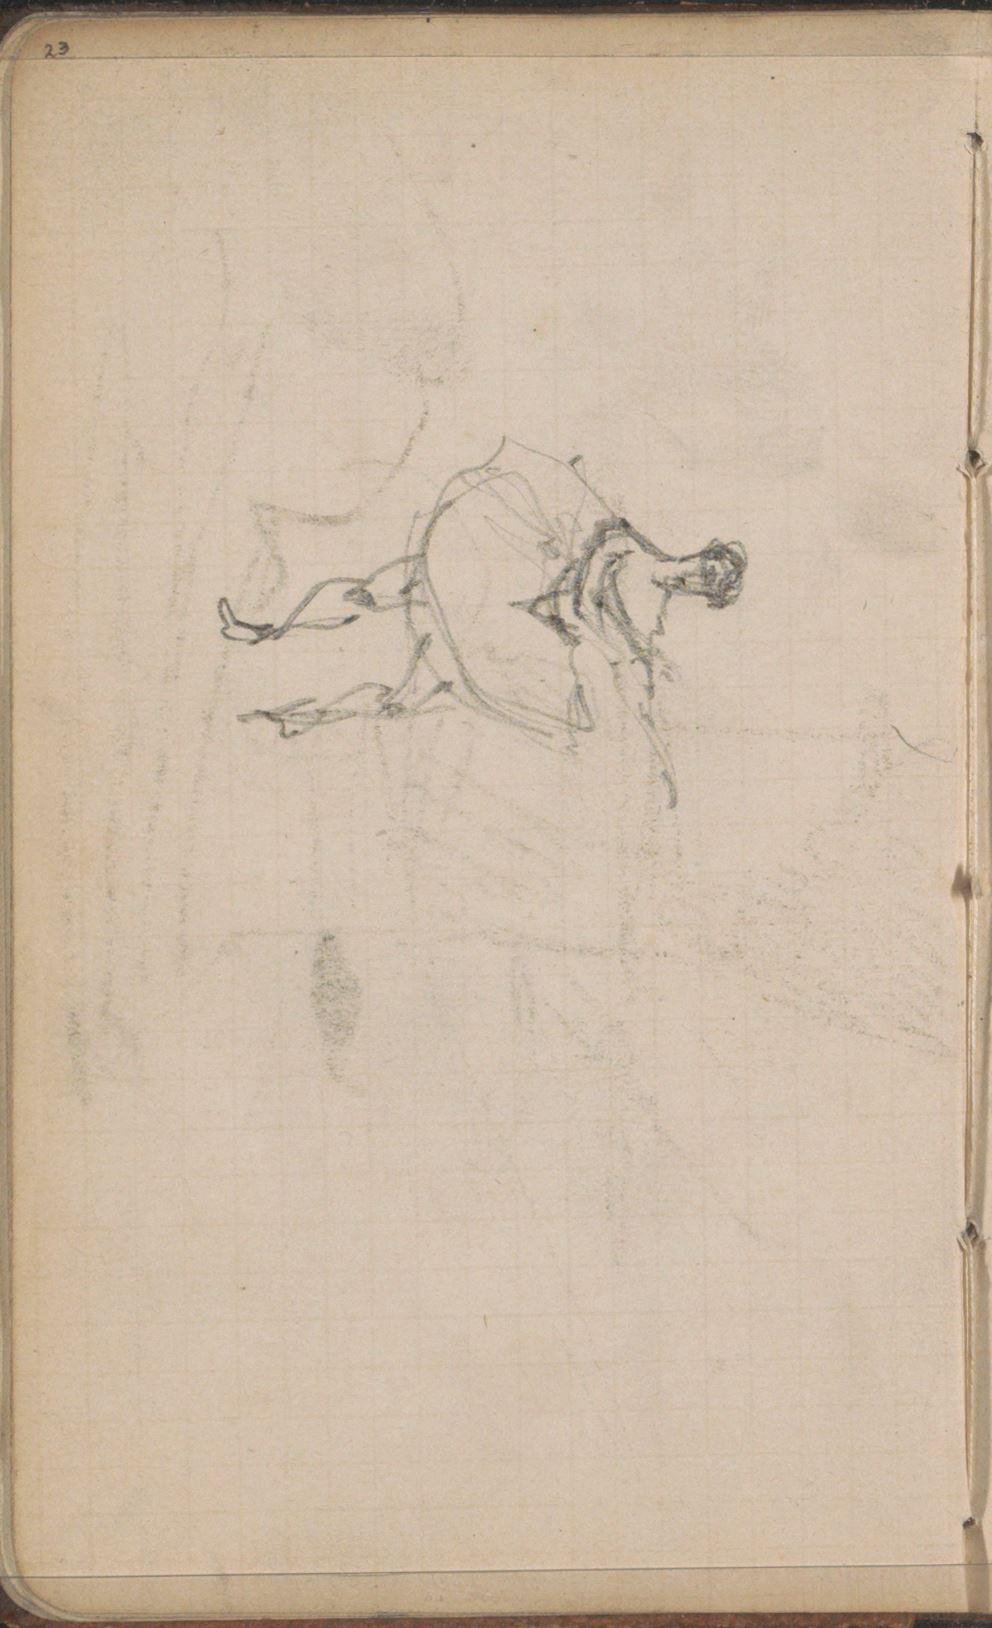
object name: sketchbook leaf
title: Ballerina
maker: marius bauer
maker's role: draughtsman, print maker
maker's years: 1867-1932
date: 1879-1885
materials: pencil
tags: the ballet, ballet performance, female dancer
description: Pagina 23 uit een schetsboek met 58 bladen.